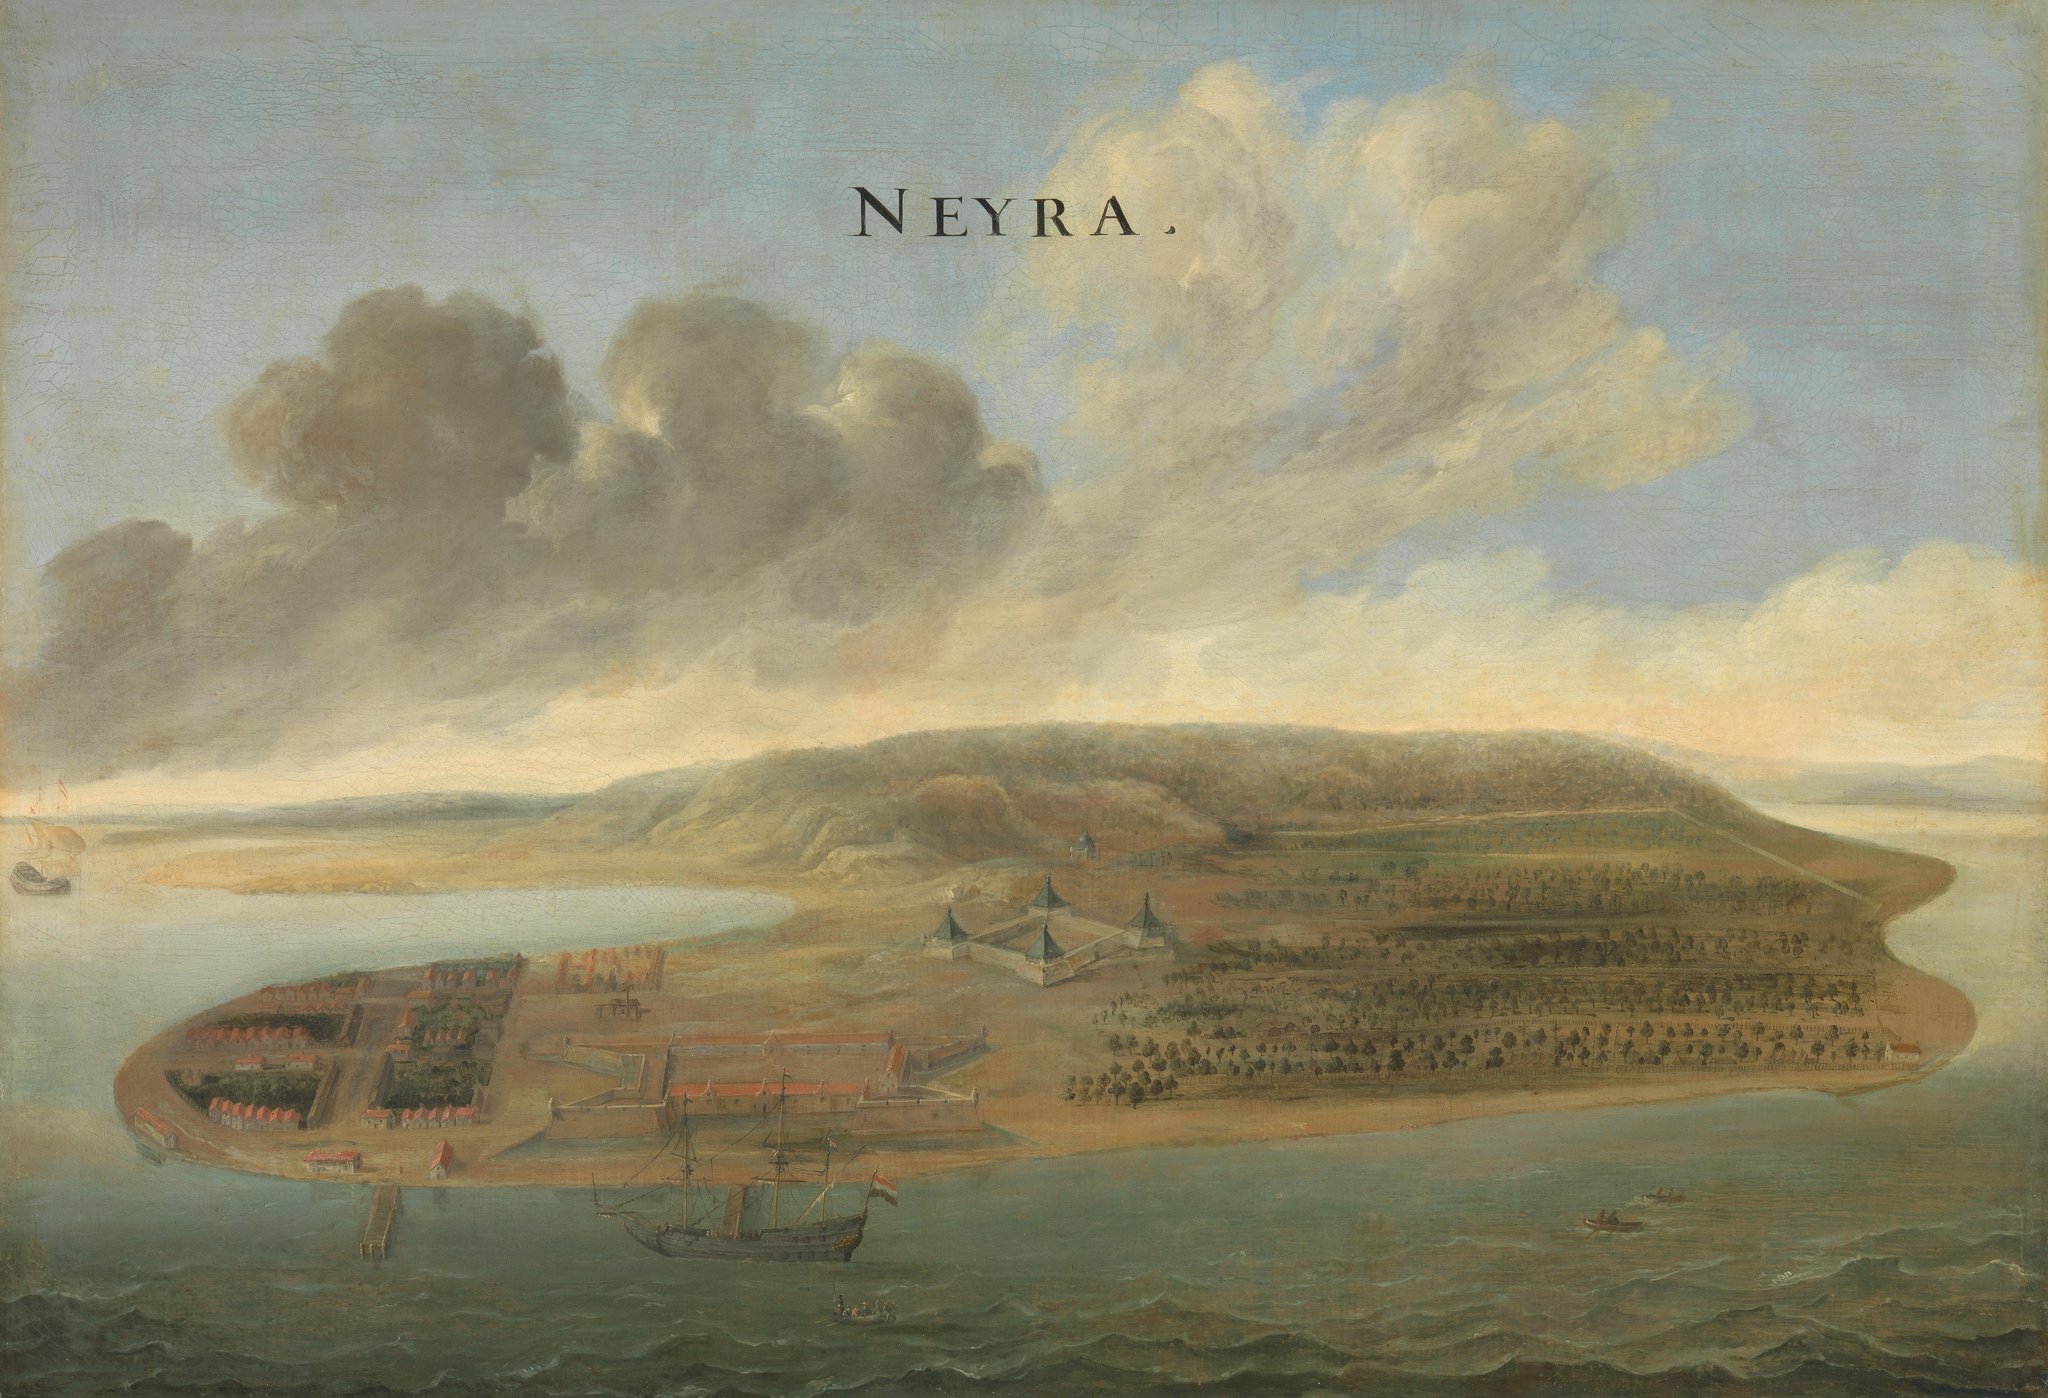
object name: painting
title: Two Views of Dutch East India Company Trading Posts: Lawec in Cambodia and Banda in the Southern Moluccas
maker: johannes vinckboons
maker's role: draughtsman, print maker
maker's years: 1616-1670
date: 1662-1663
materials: linen, oil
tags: island, locations for trading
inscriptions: inscription: ‘Neyra.’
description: From 1609 the East India Company was sailing to Lawec, near Phnom Penh. There the company purchased provisions, such as rice, butter, pork, and lard, for Batavia. Banda supplied mace and nutmeg. In 1621, Governor-General Coen punished the island for trading with other countries: all fifteen thousand islanders were killed or driven away. The ‘slaughterer of Banda’ founded nutmeg parcels, heavily guarded by forts.